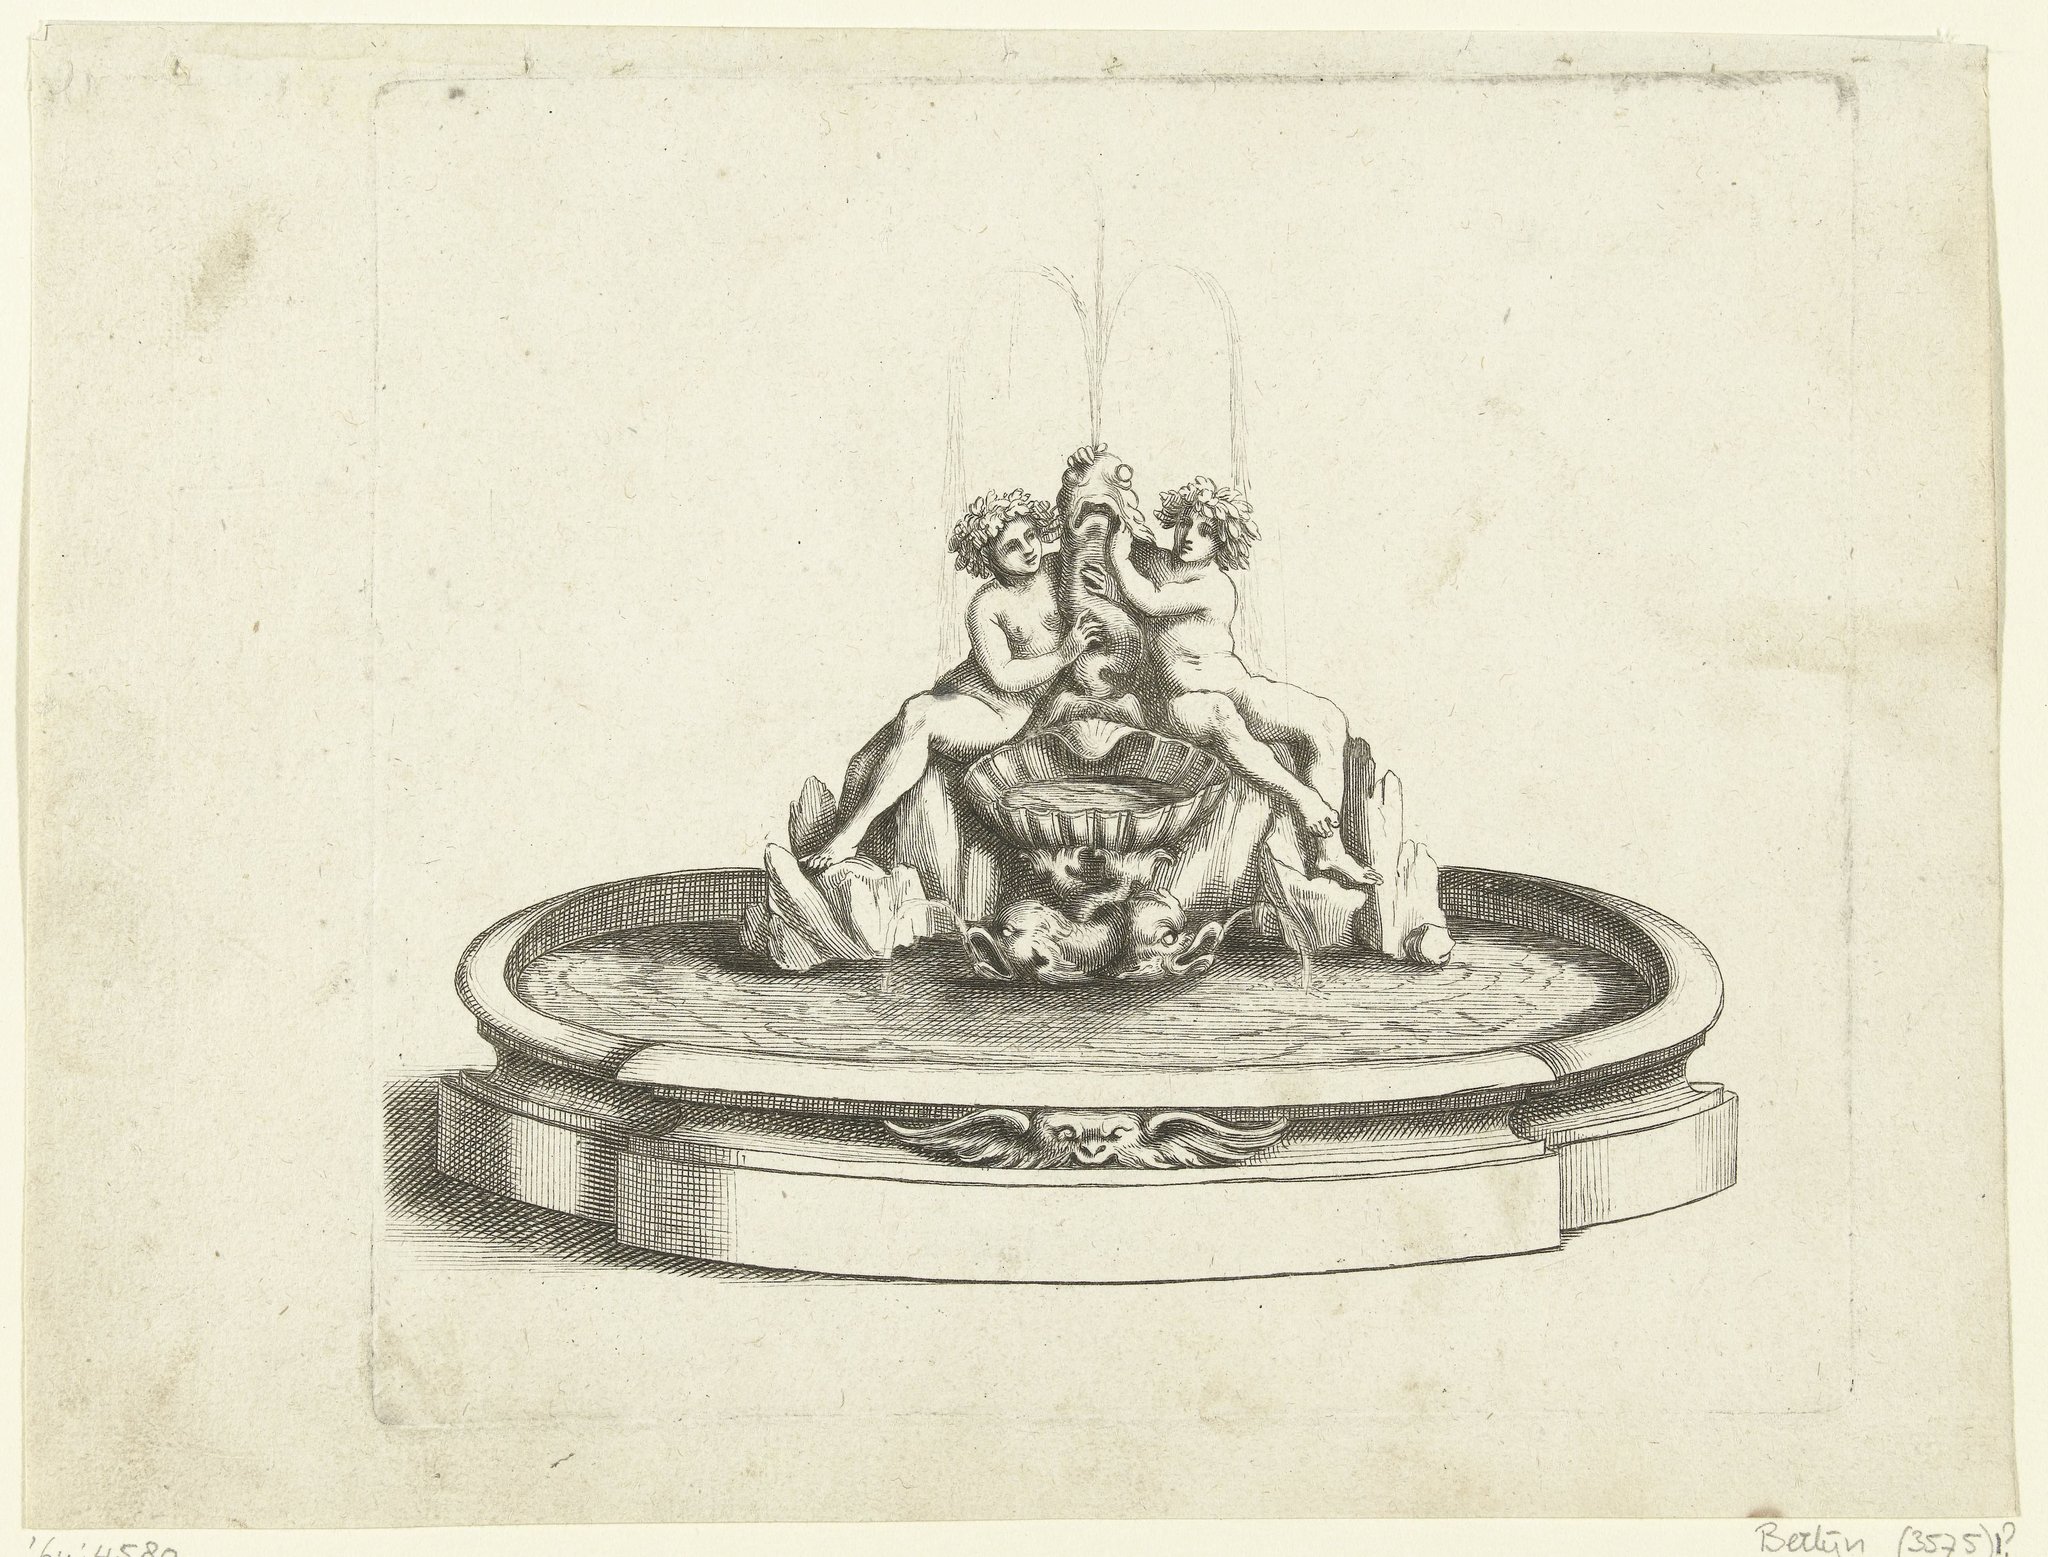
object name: print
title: Fontaines Et Iets D'Eau (...)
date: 1680-1707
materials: paper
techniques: engraving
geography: paris